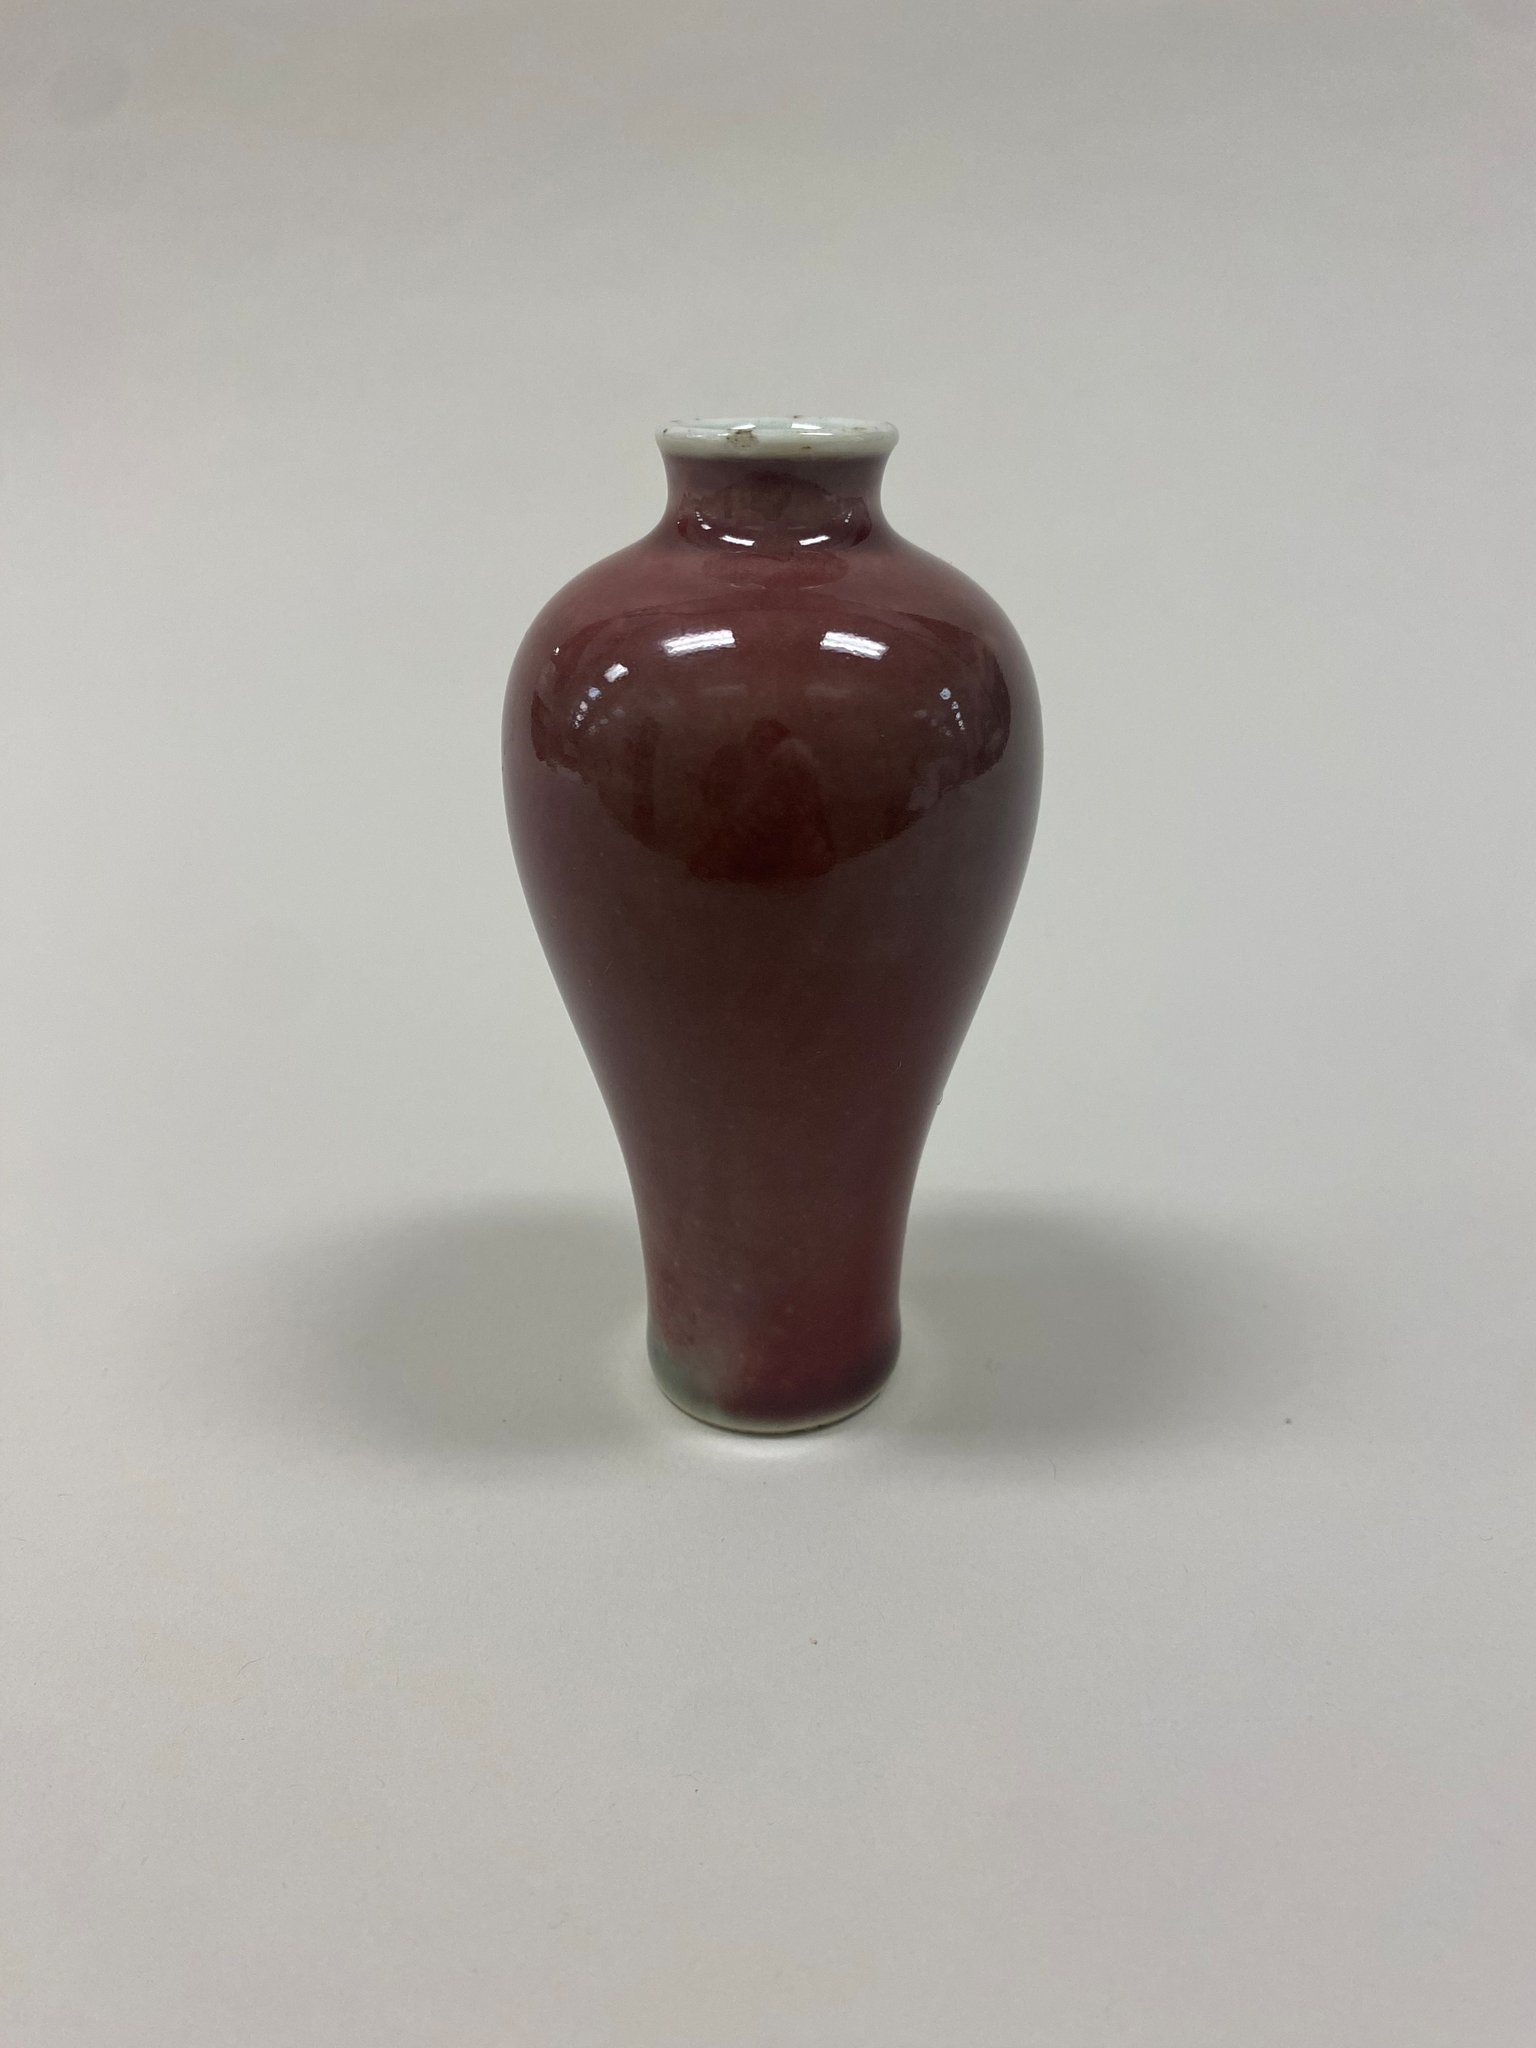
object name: vase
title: Meiping vase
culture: chinese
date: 1701-1800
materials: copper, glaze, porcelain